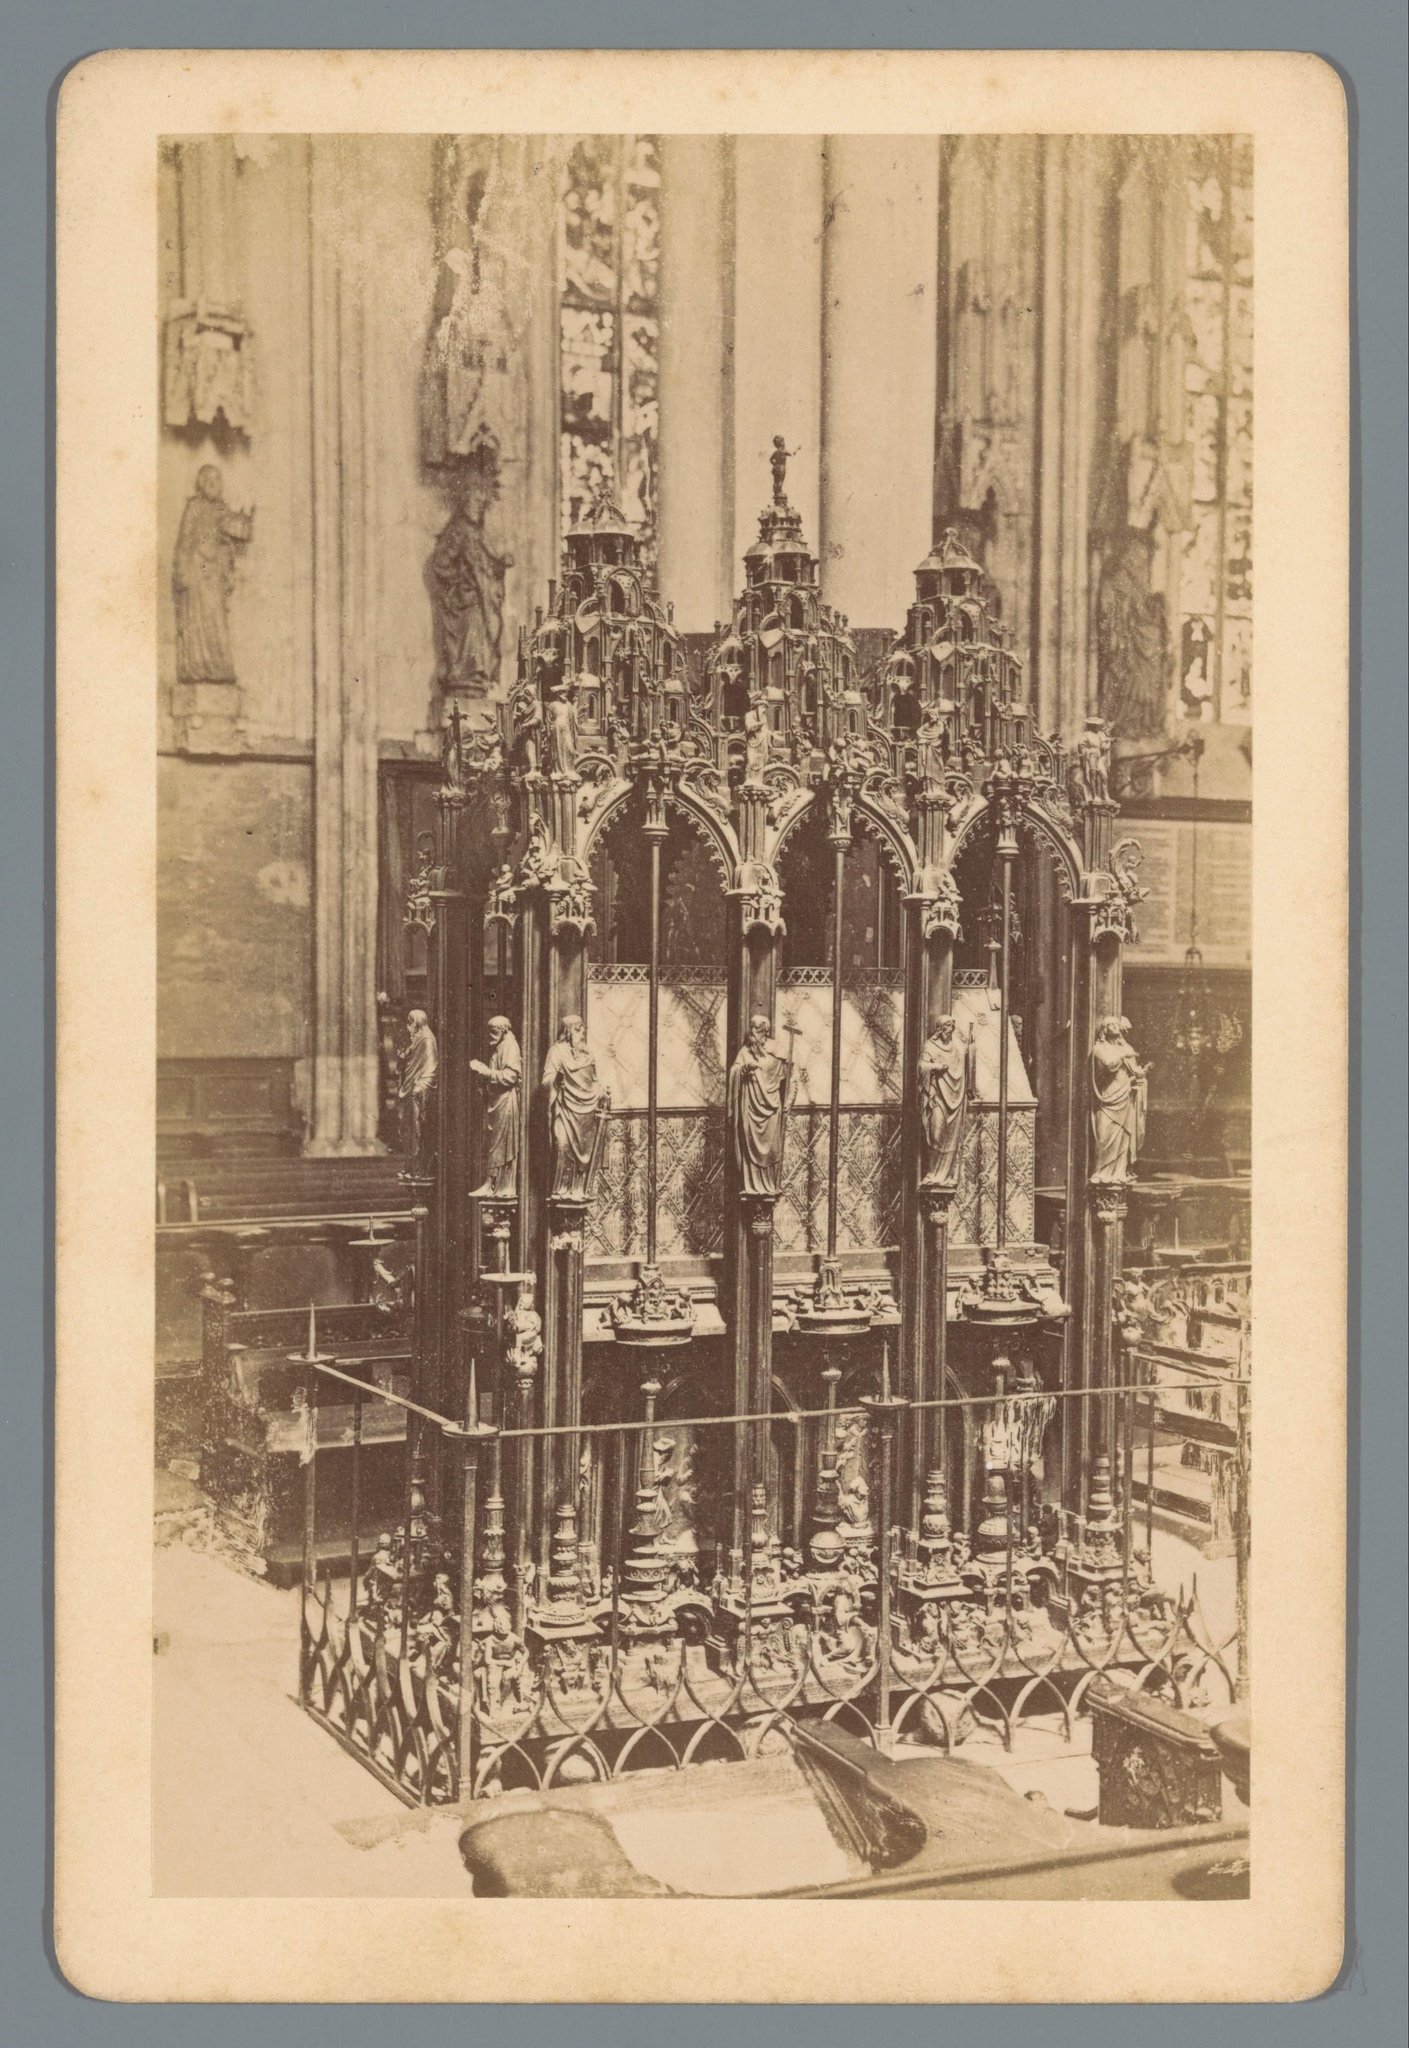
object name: cabinet photograph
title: Nürnberg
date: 1863-1898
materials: cardboard, photographic support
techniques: albumen print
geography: sint-sebalduskerk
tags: grave, tomb, parts of church interior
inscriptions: number: ‘9.’